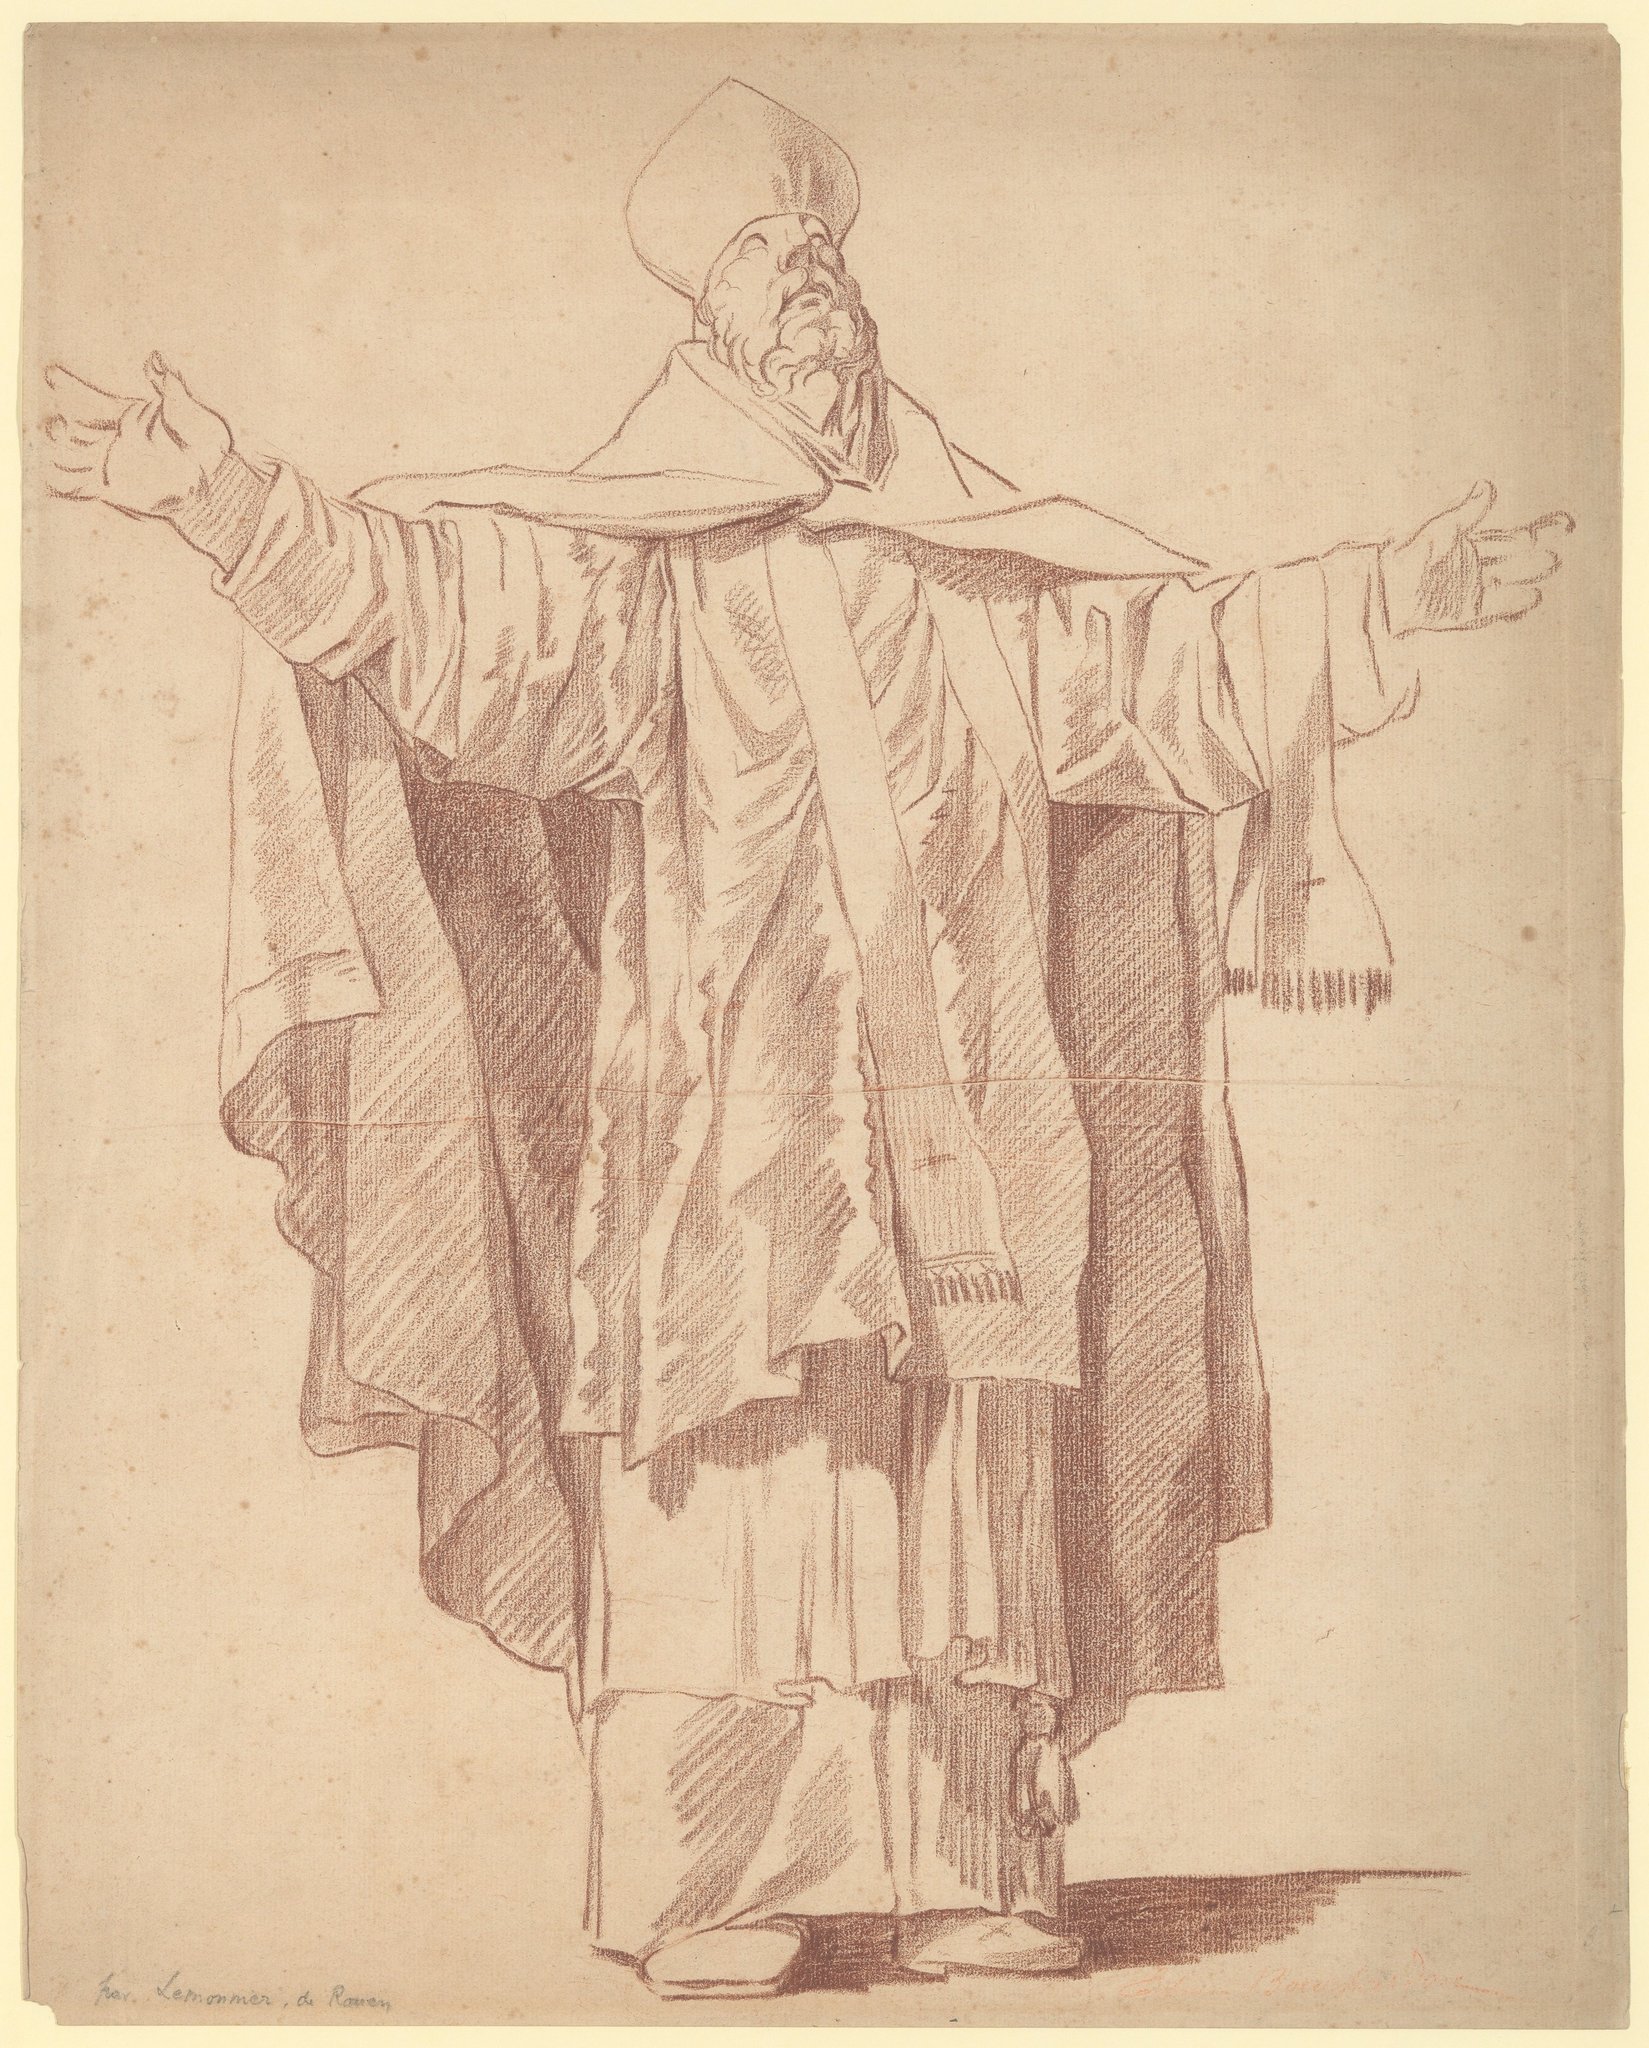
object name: drawing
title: Standing Ecclesiastic With Arms Upraised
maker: anicet charles gabriel lemonnier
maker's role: artist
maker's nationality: french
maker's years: 1743-1824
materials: chalk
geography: france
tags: men